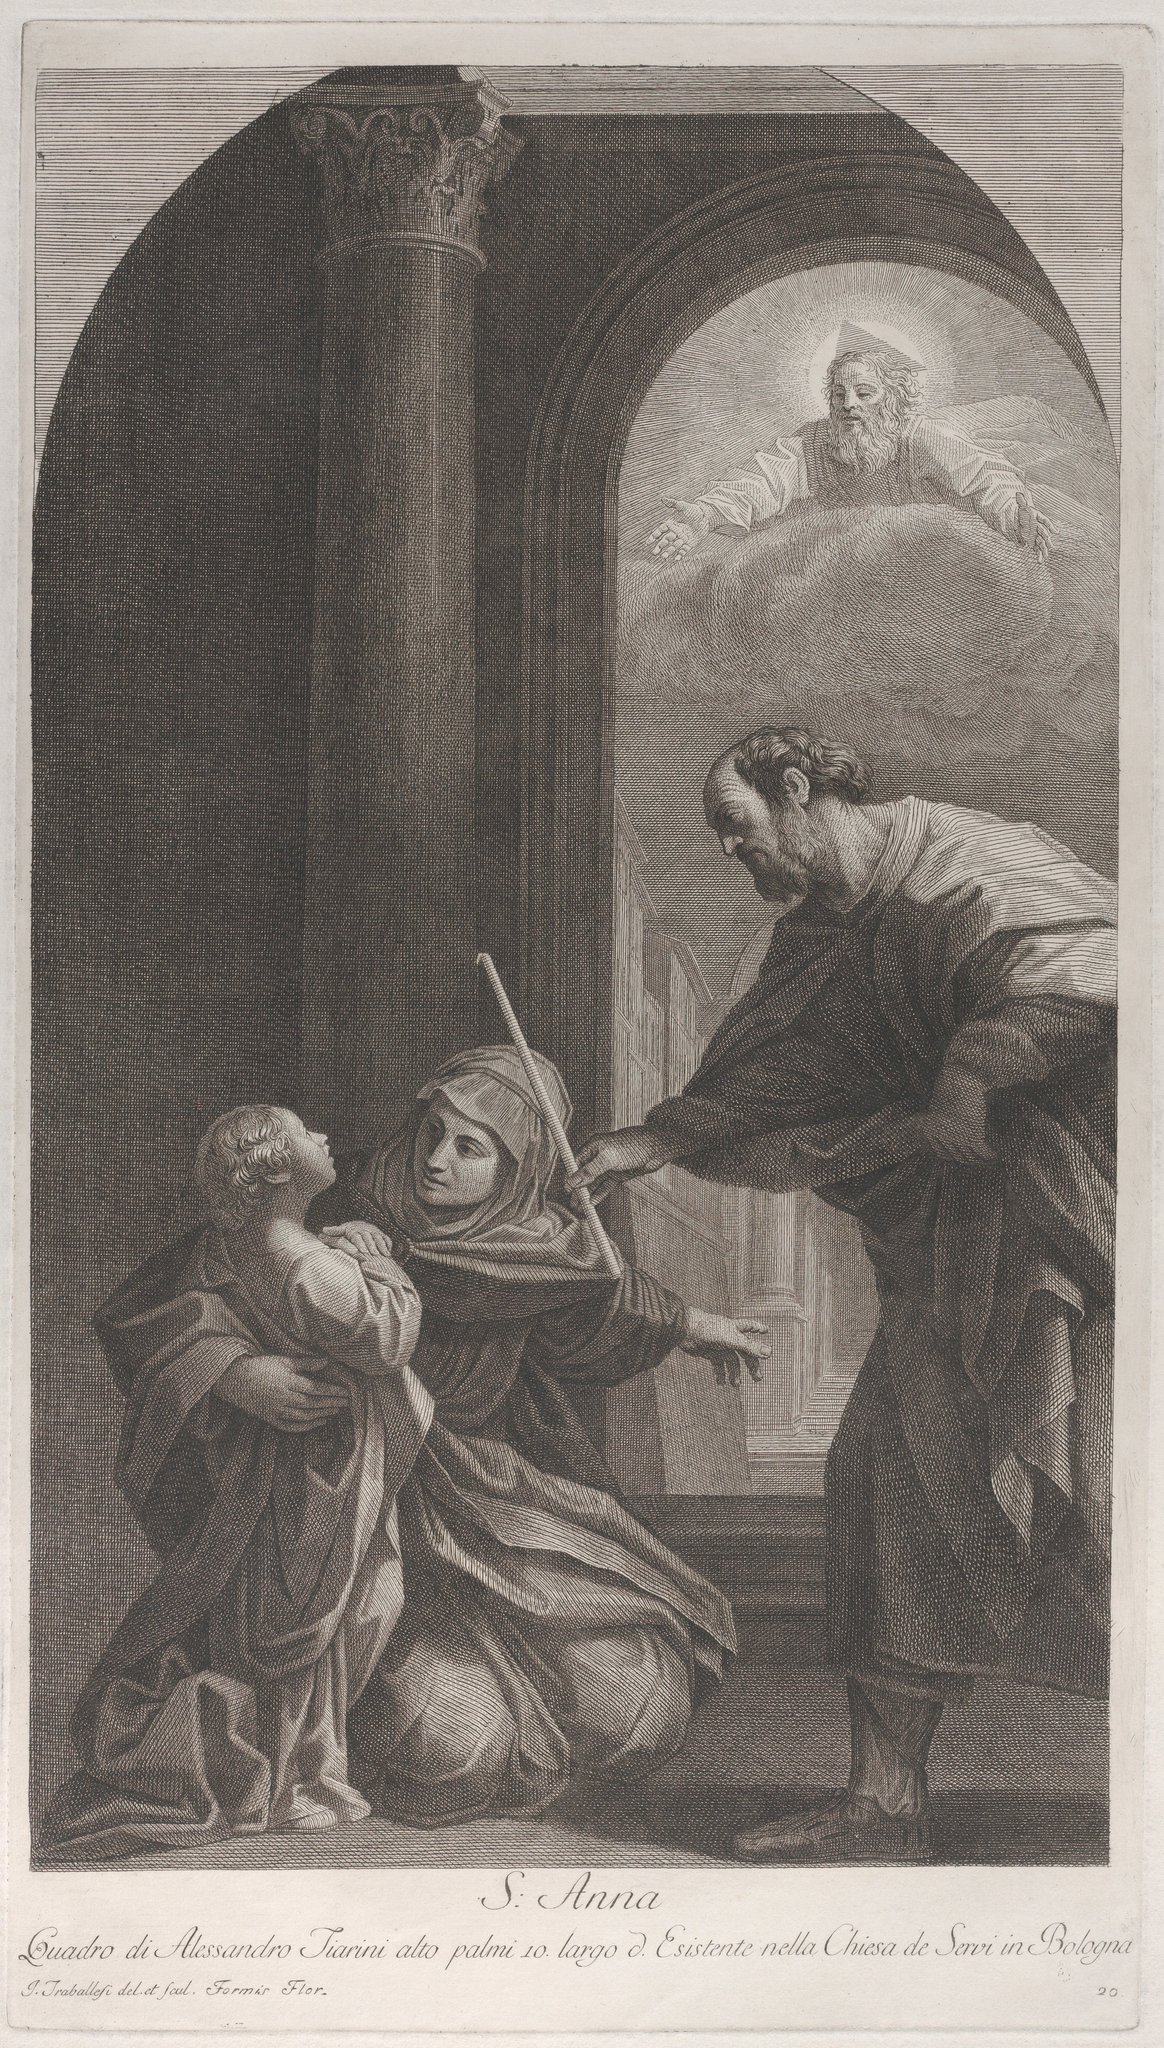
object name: print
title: Saint Anne kneeling holding the Virgin, with Saint Joachim holding his staff at right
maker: giuliano traballesi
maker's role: artist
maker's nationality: italian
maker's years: 1727-1812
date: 1760-1800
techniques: engraving, etching